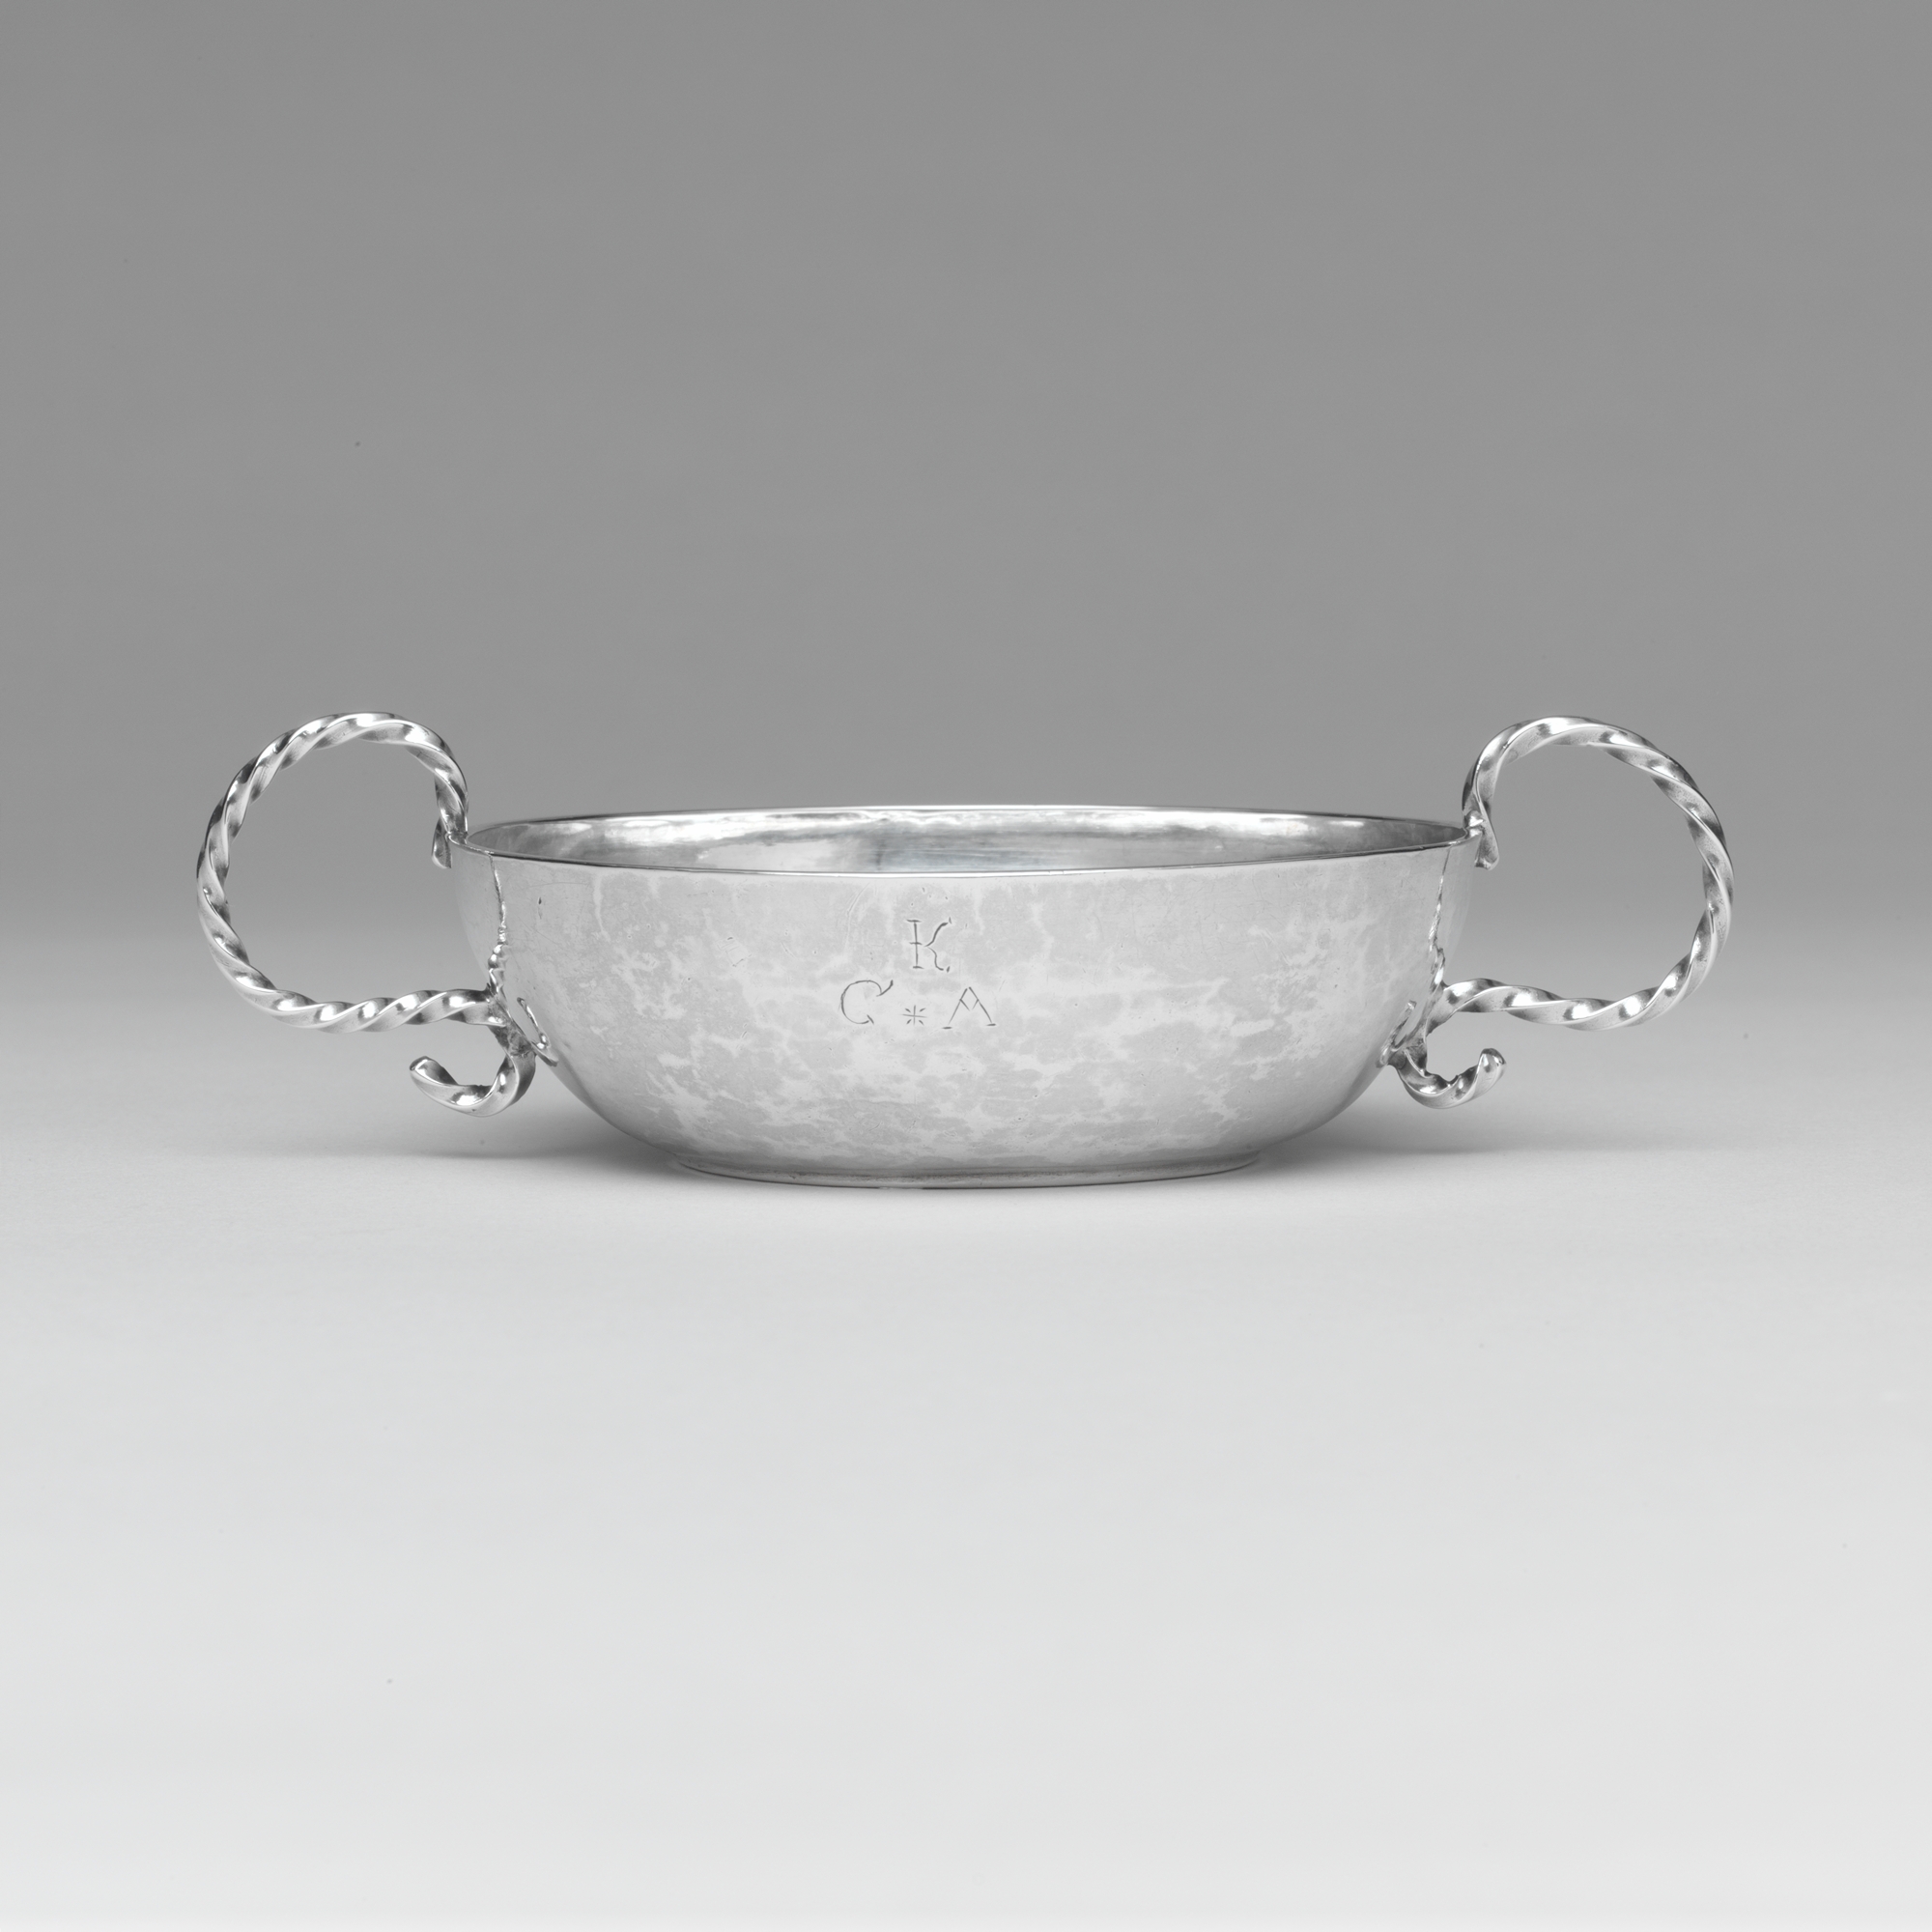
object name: dram cup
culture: american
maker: jacob boelen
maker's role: maker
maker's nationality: american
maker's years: 1657-1729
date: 1690-1700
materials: silver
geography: united states